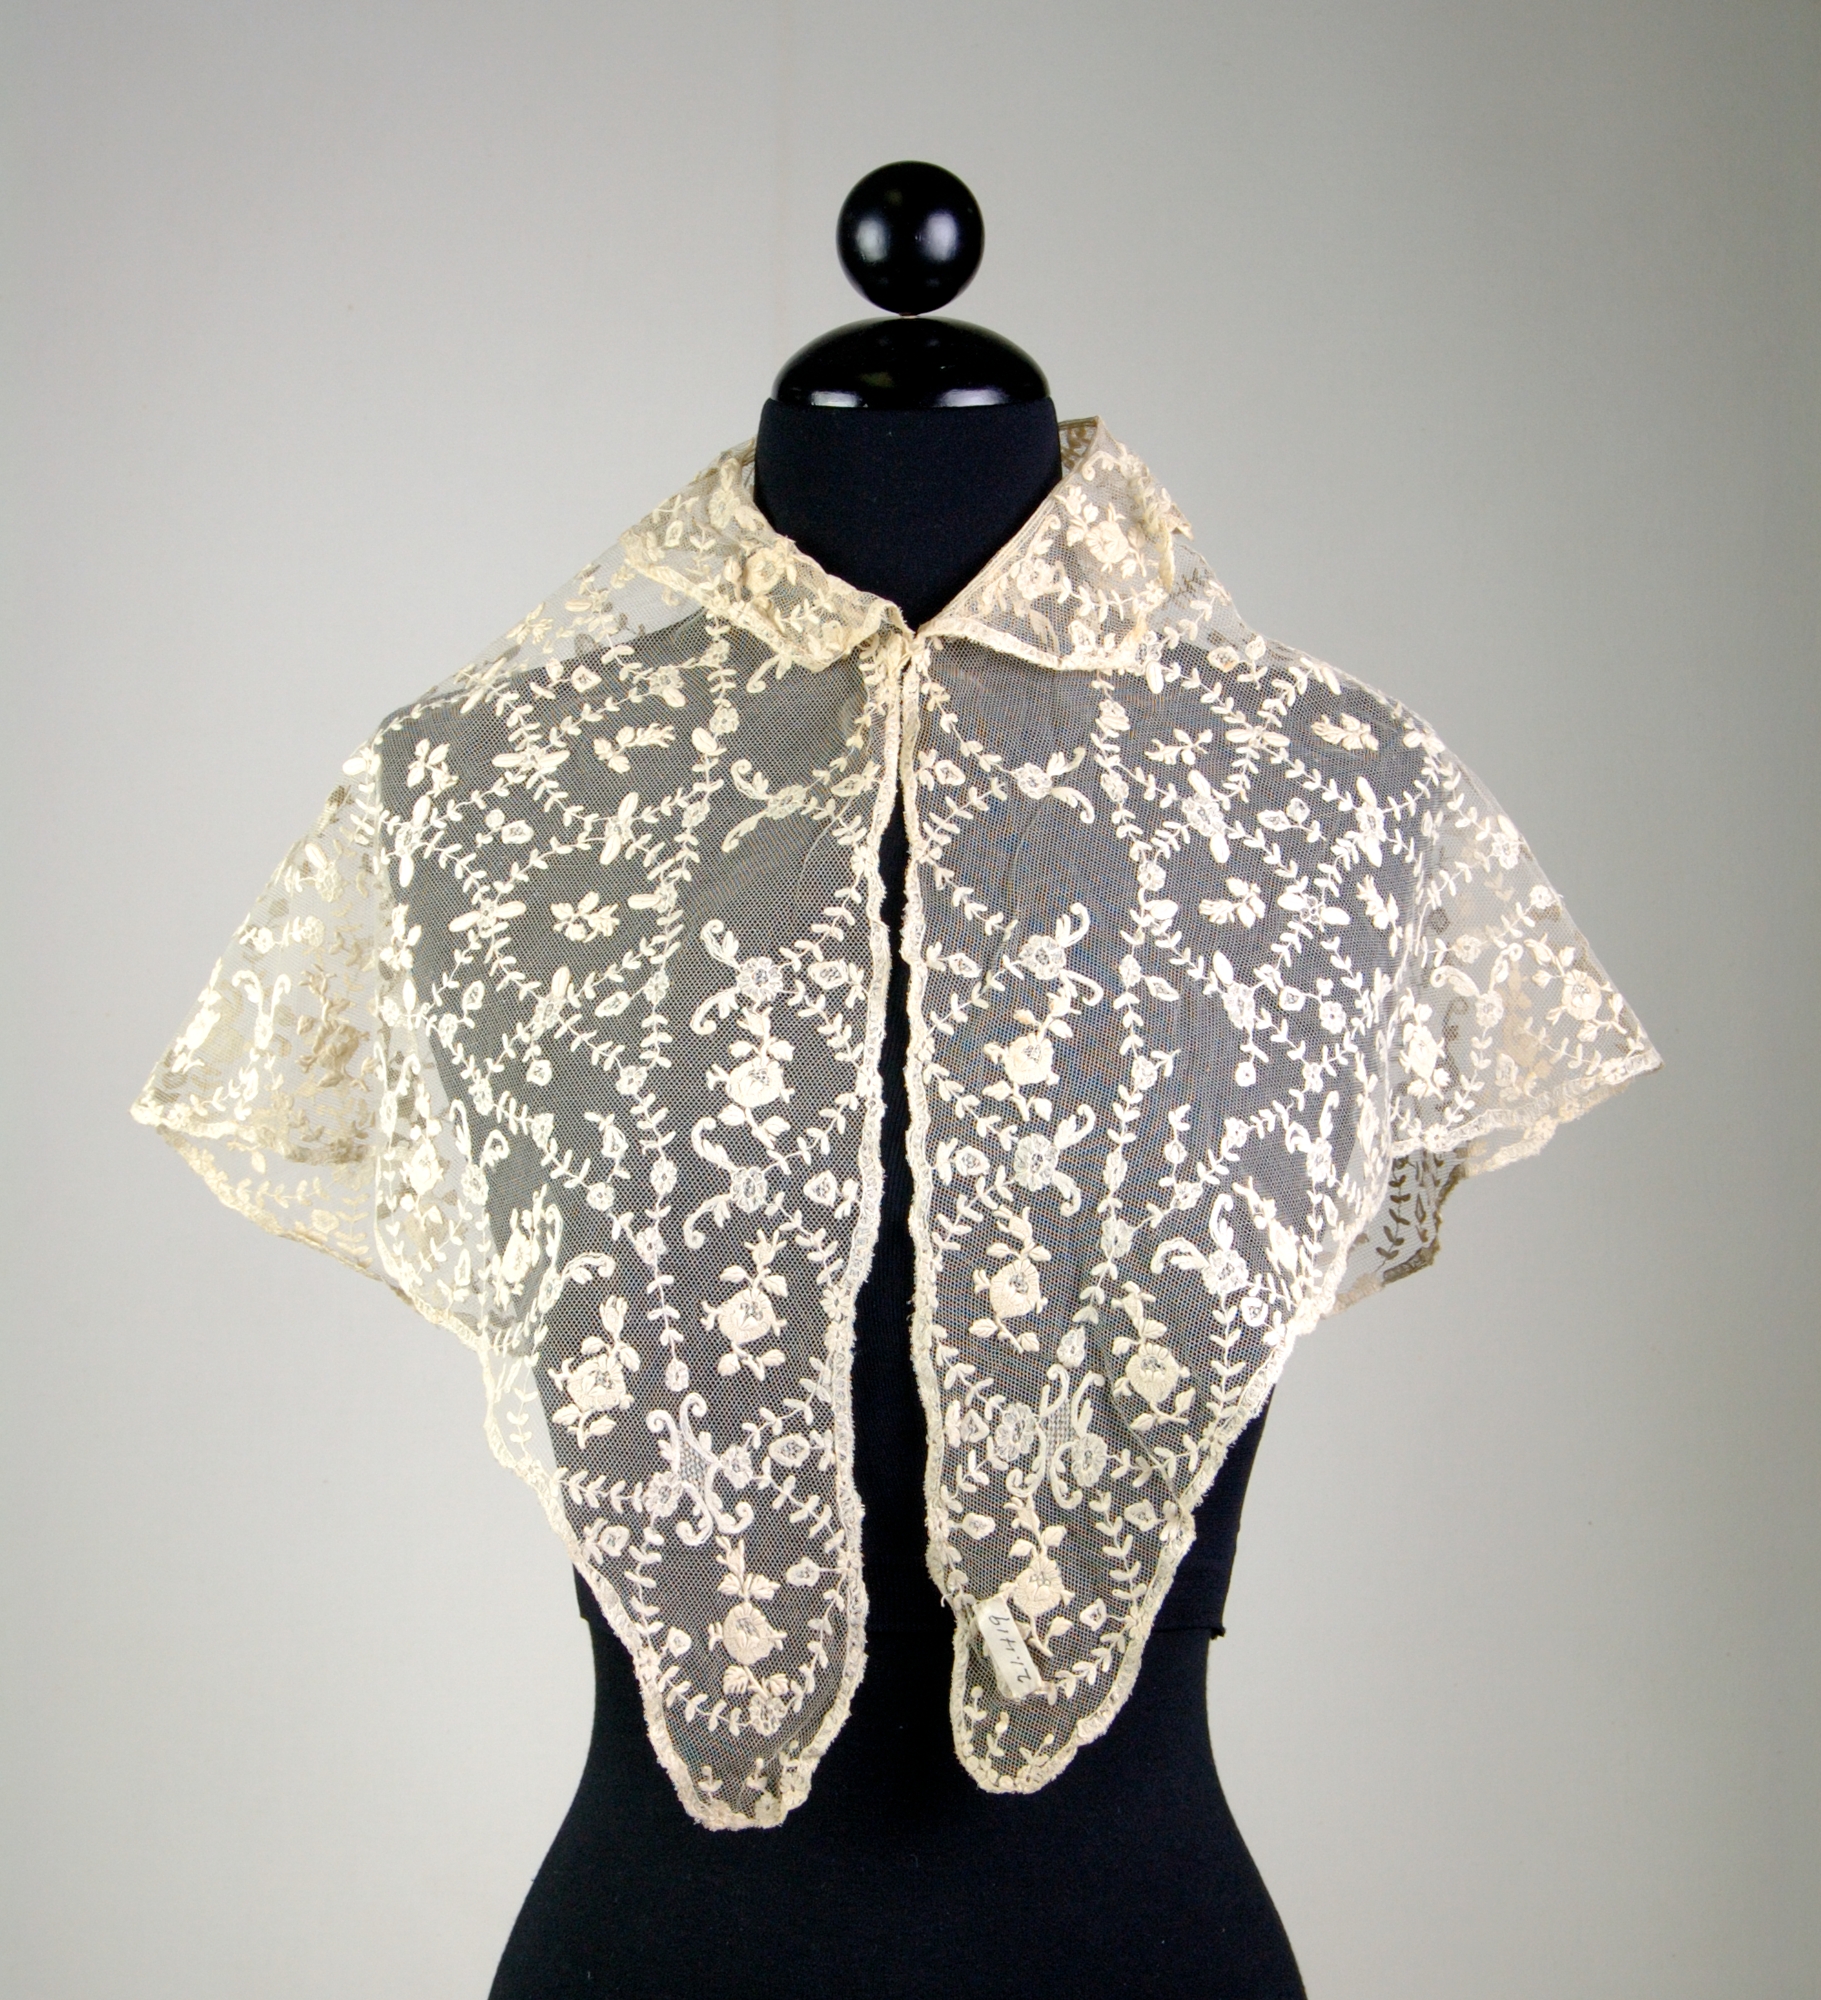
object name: pelerine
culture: irish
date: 1851-1875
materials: cotton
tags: flowers